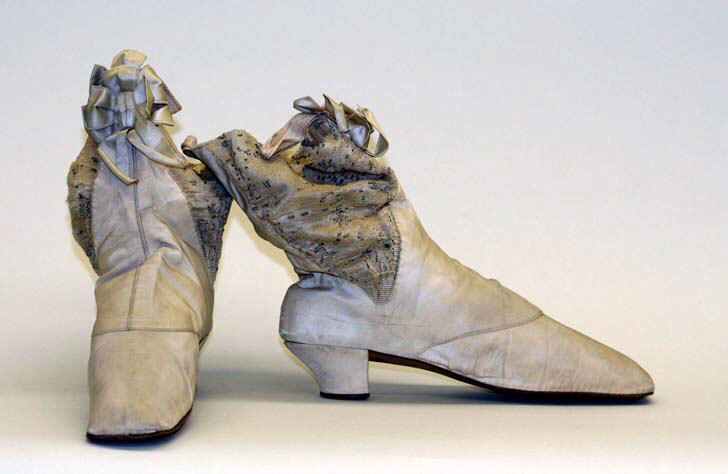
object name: boot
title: Boots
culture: european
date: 1874